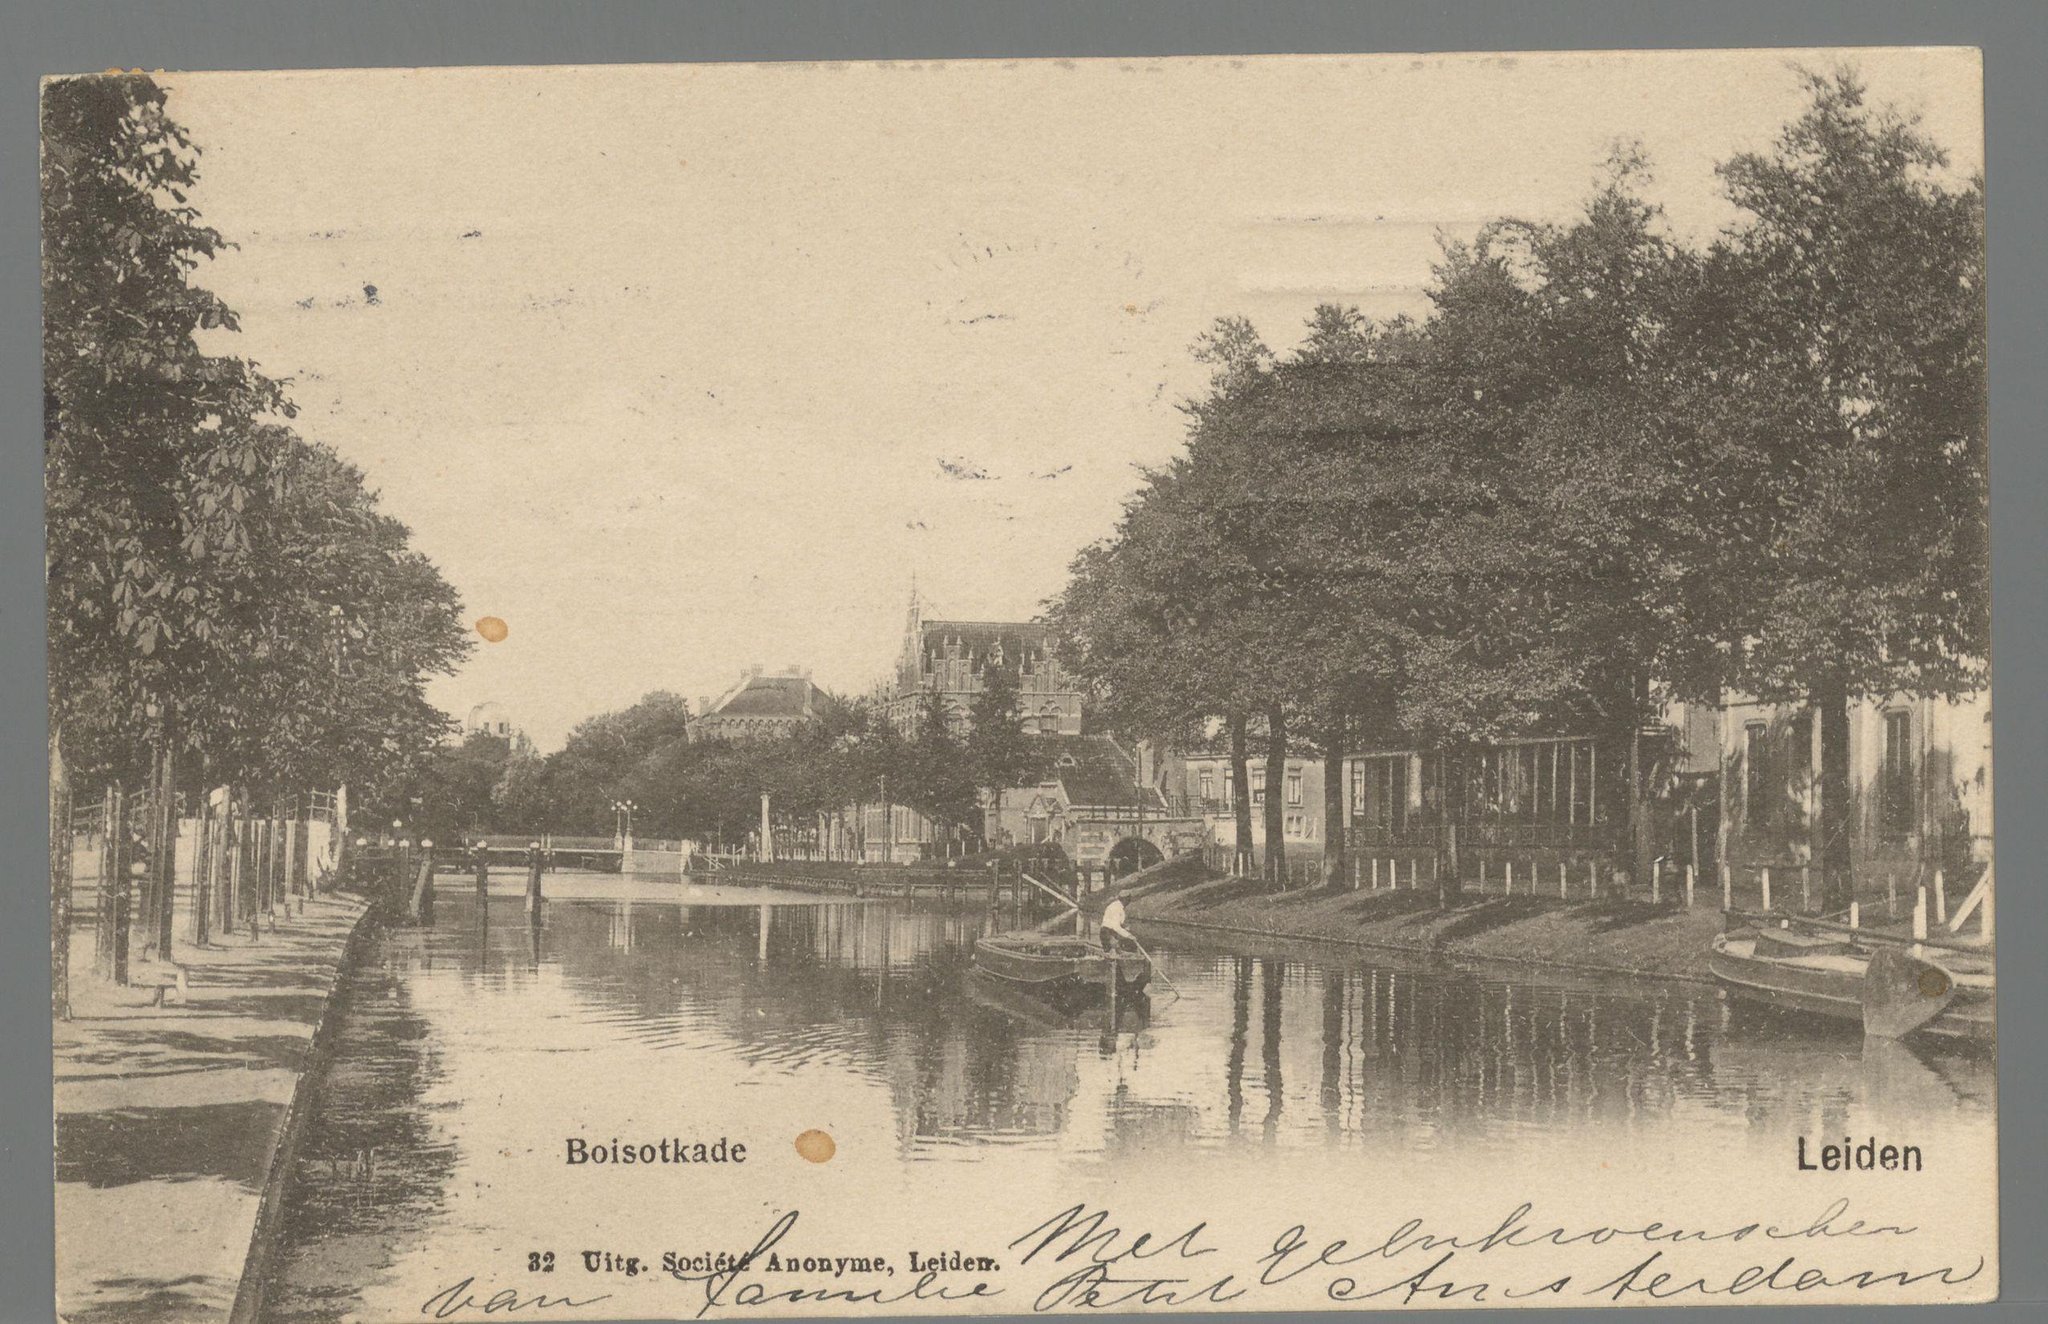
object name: photomechanical print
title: Boisotkade. Leiden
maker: Anonymous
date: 1892-1905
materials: cardboard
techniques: photograph, writing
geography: leiden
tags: canal, street, leiden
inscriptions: postage stamp